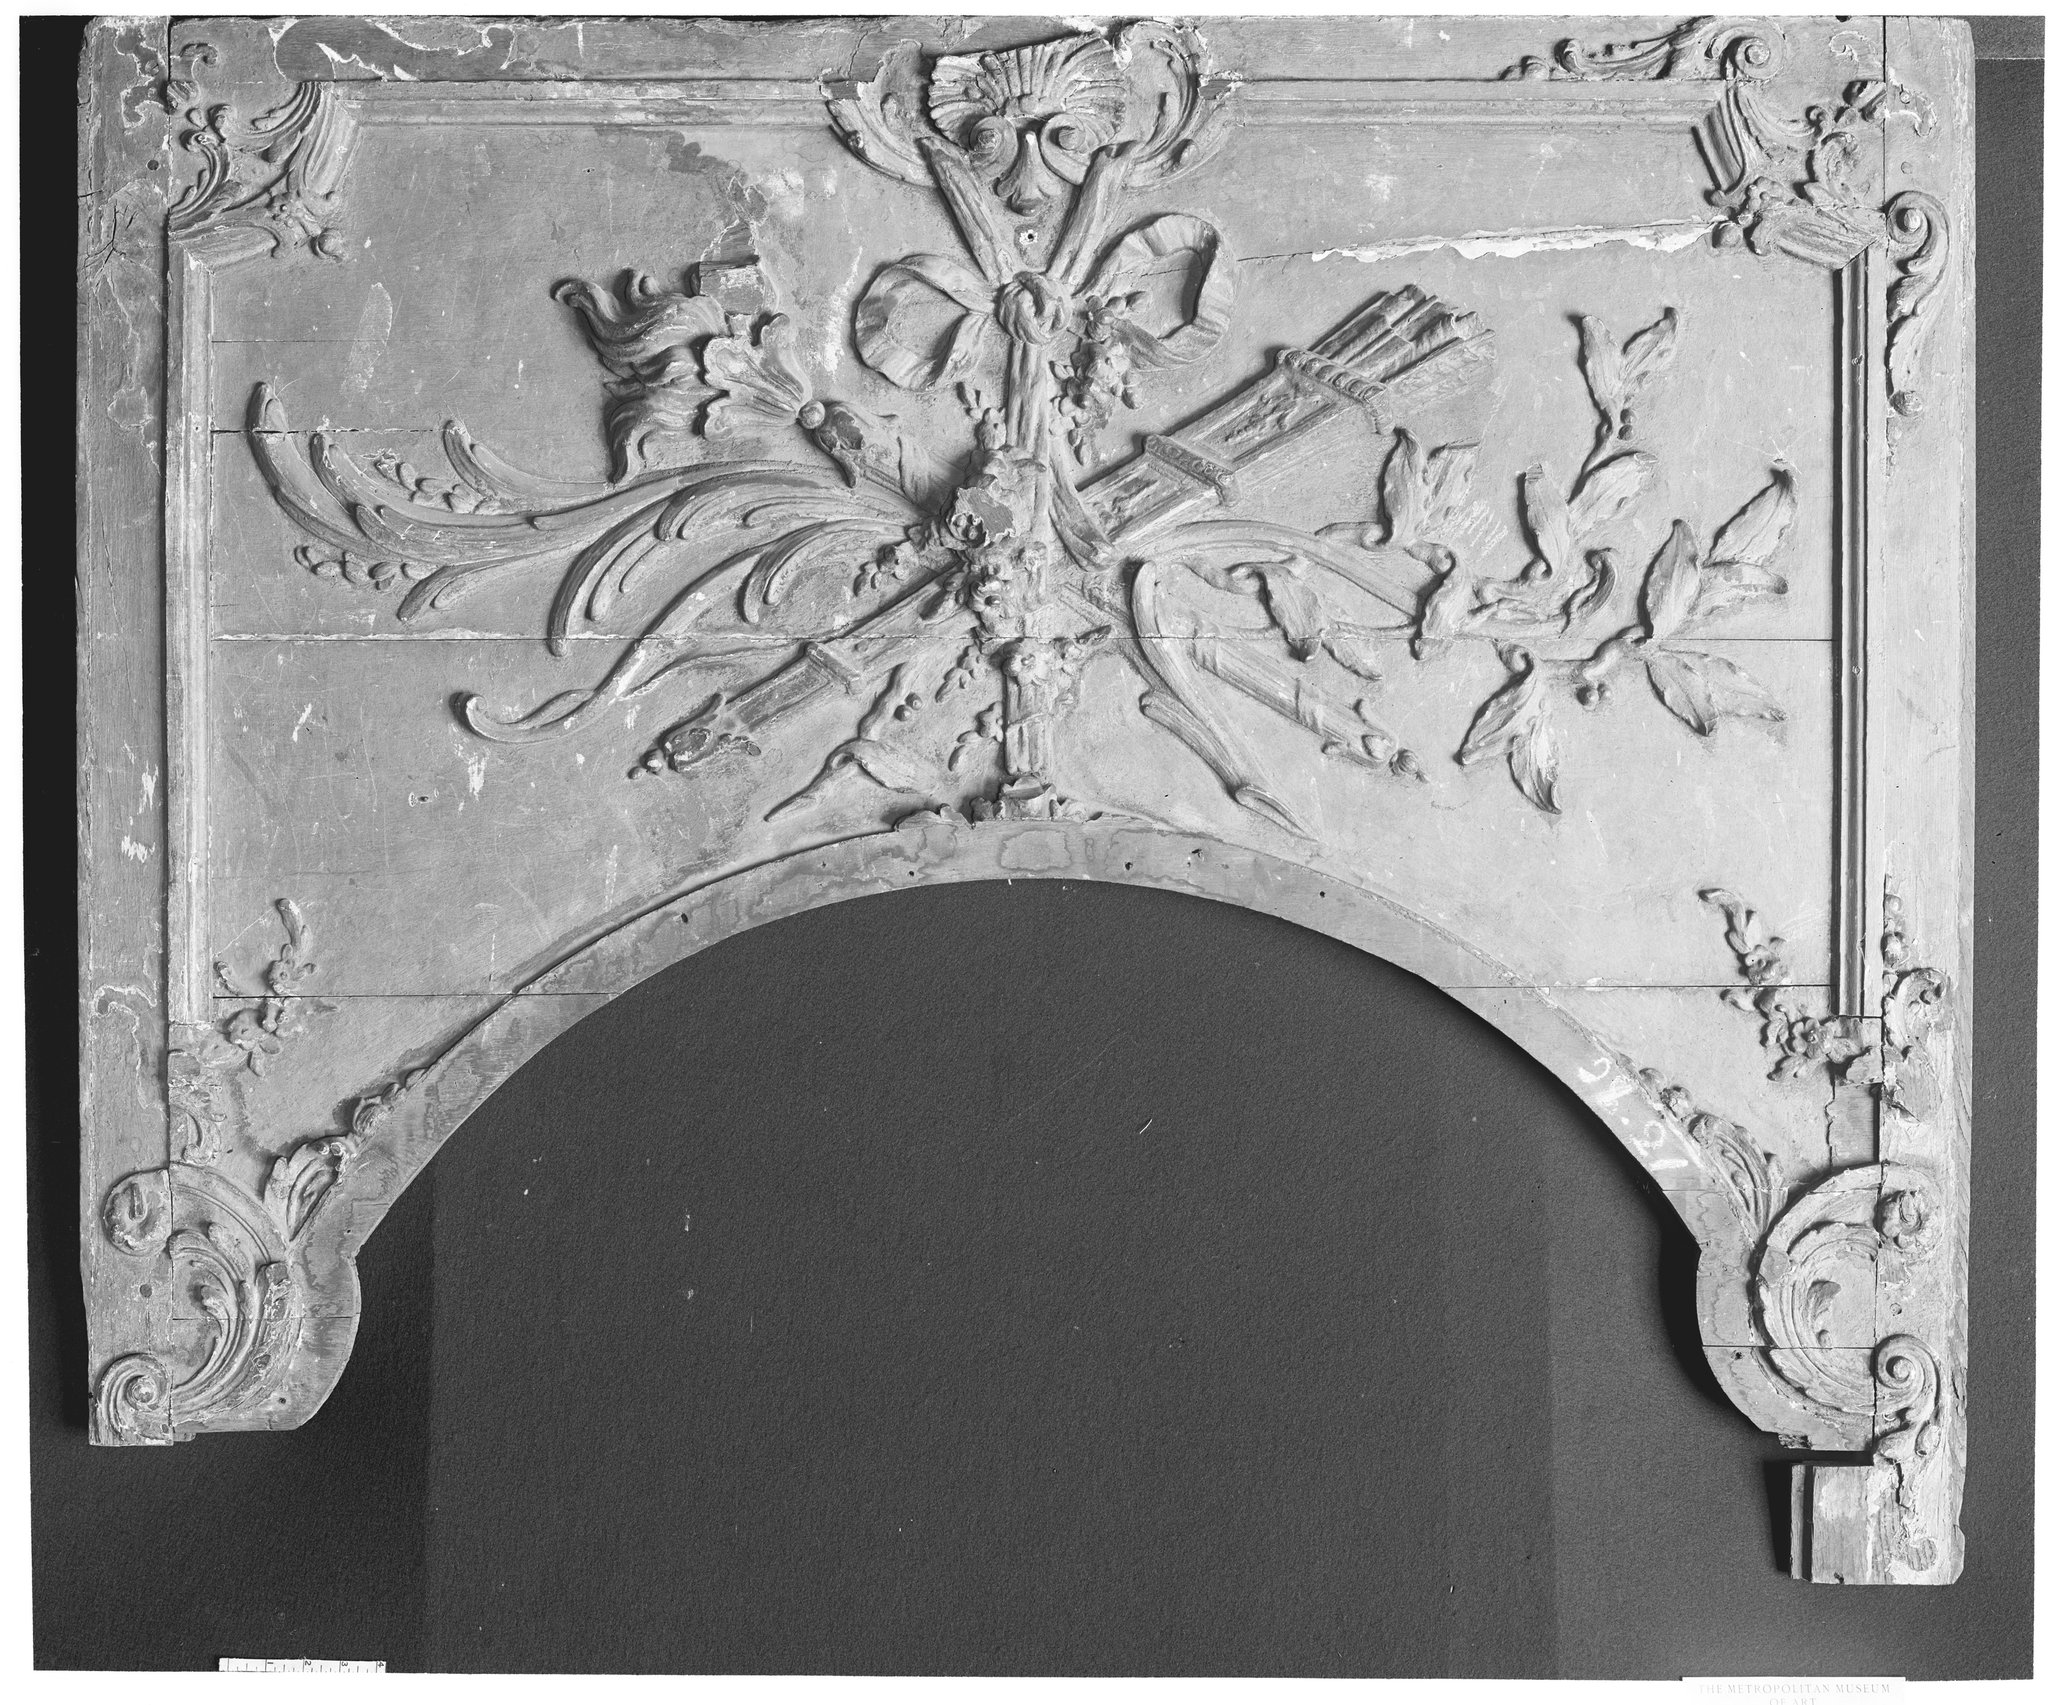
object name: mirror frame panel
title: Panel from the top of a mirror frame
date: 1701-1800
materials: wood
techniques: carving, painting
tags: flowers,leaves